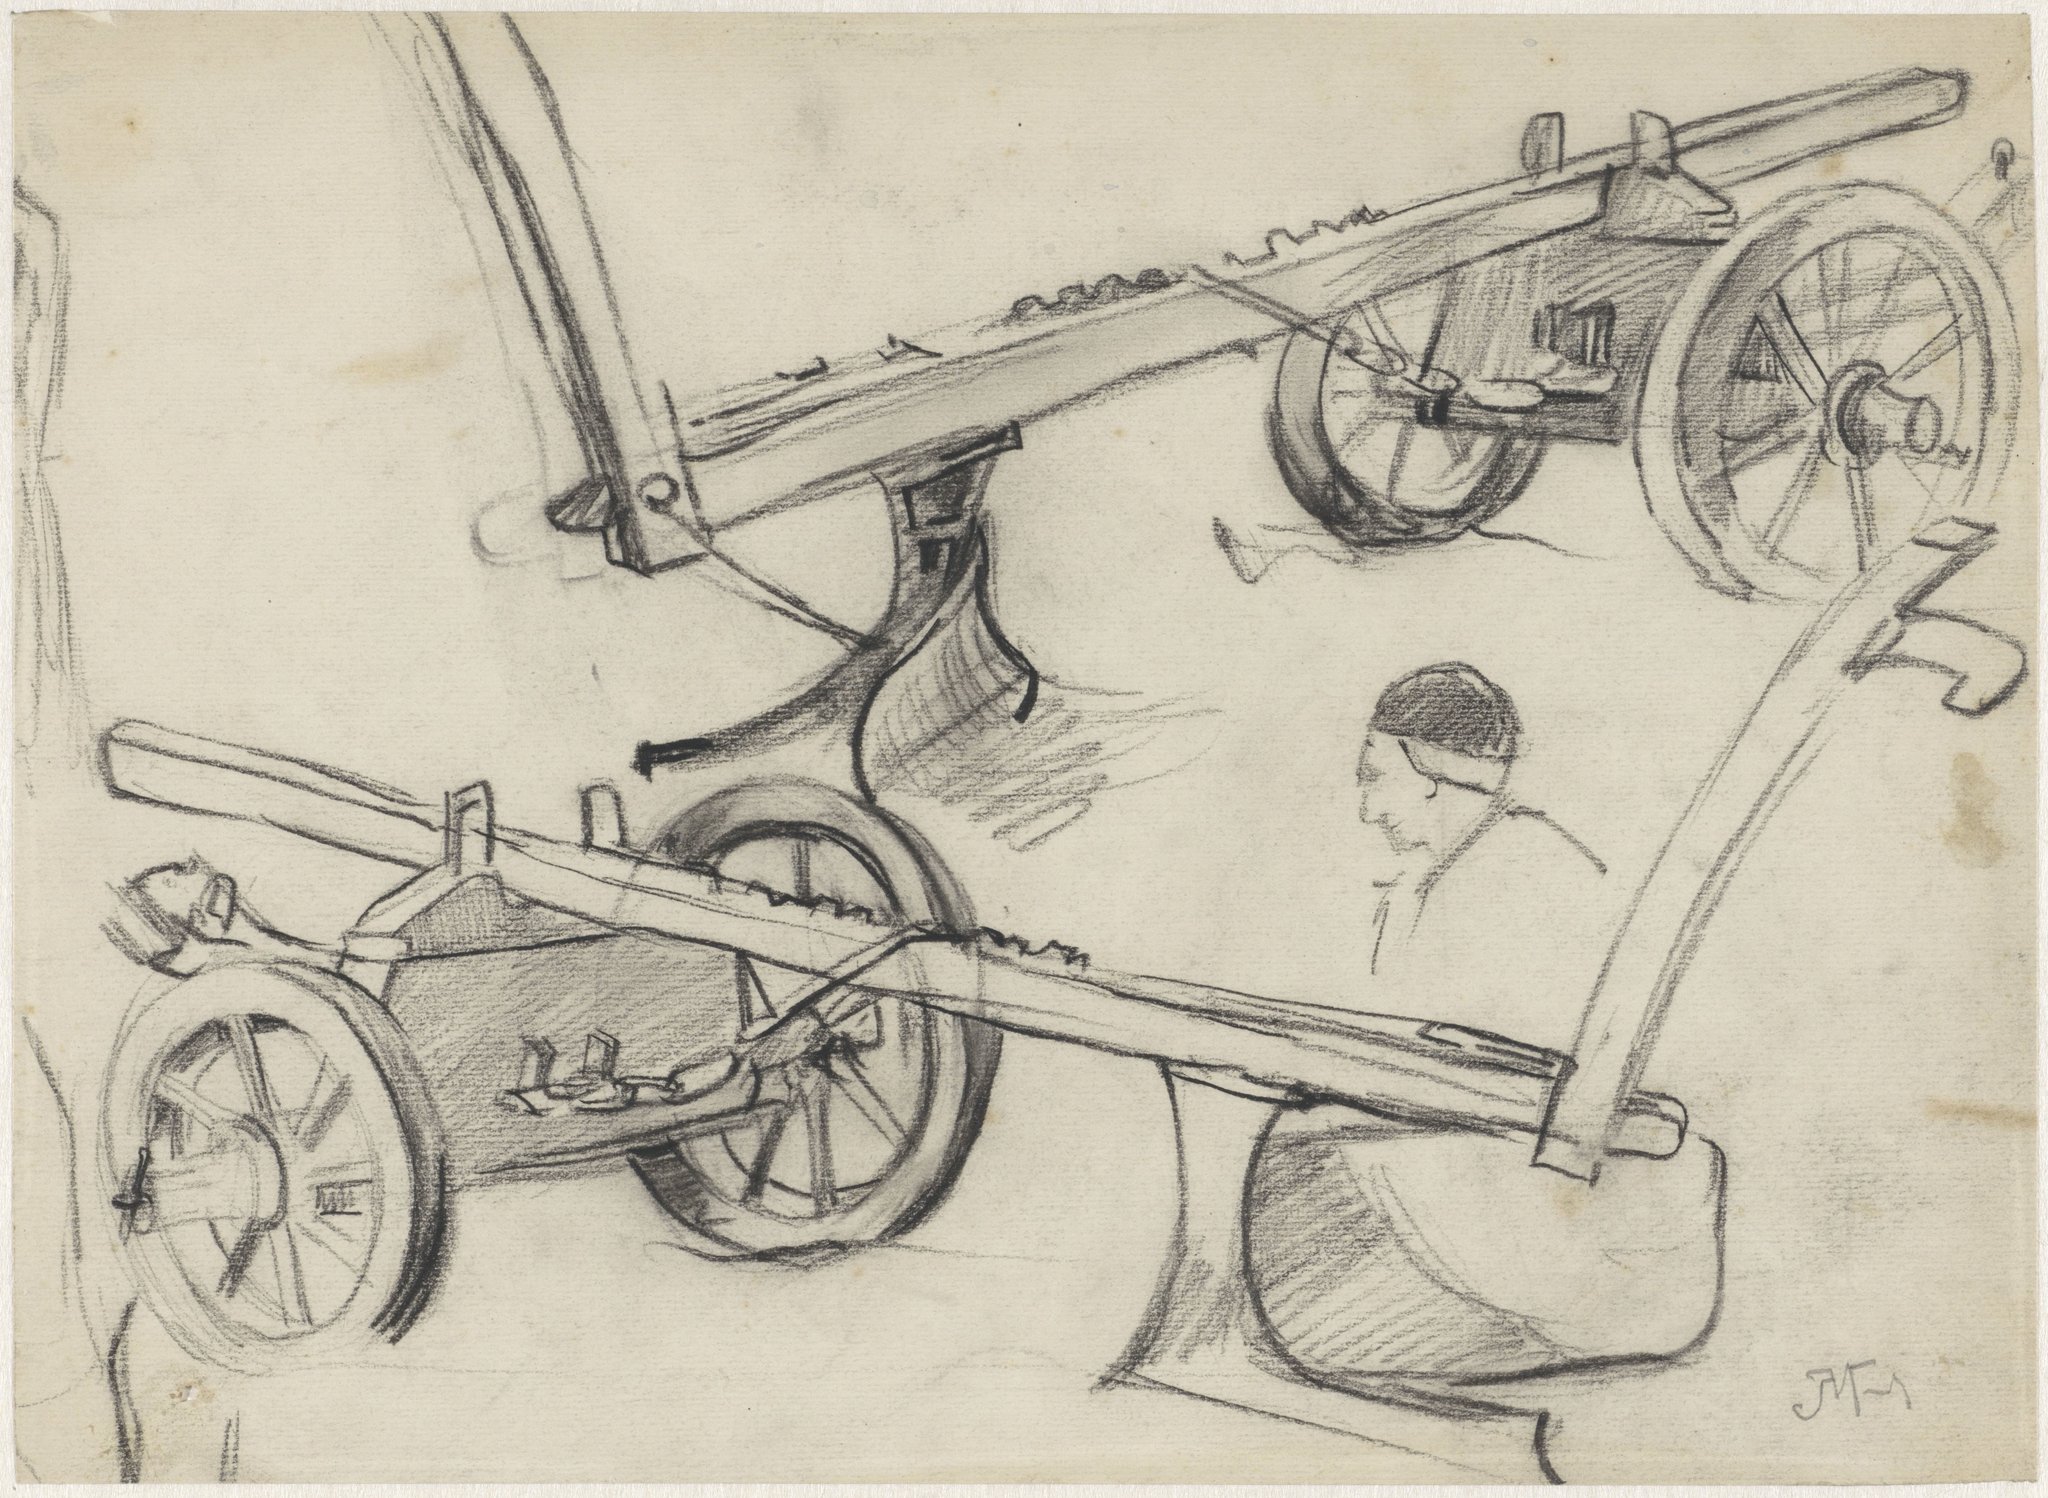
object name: drawing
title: Studies van een ploeg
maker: johannes abraham mondt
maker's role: draughtsman, print maker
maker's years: 1859-1941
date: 1869-1941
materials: chalk, paper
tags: agricultural implements: plough